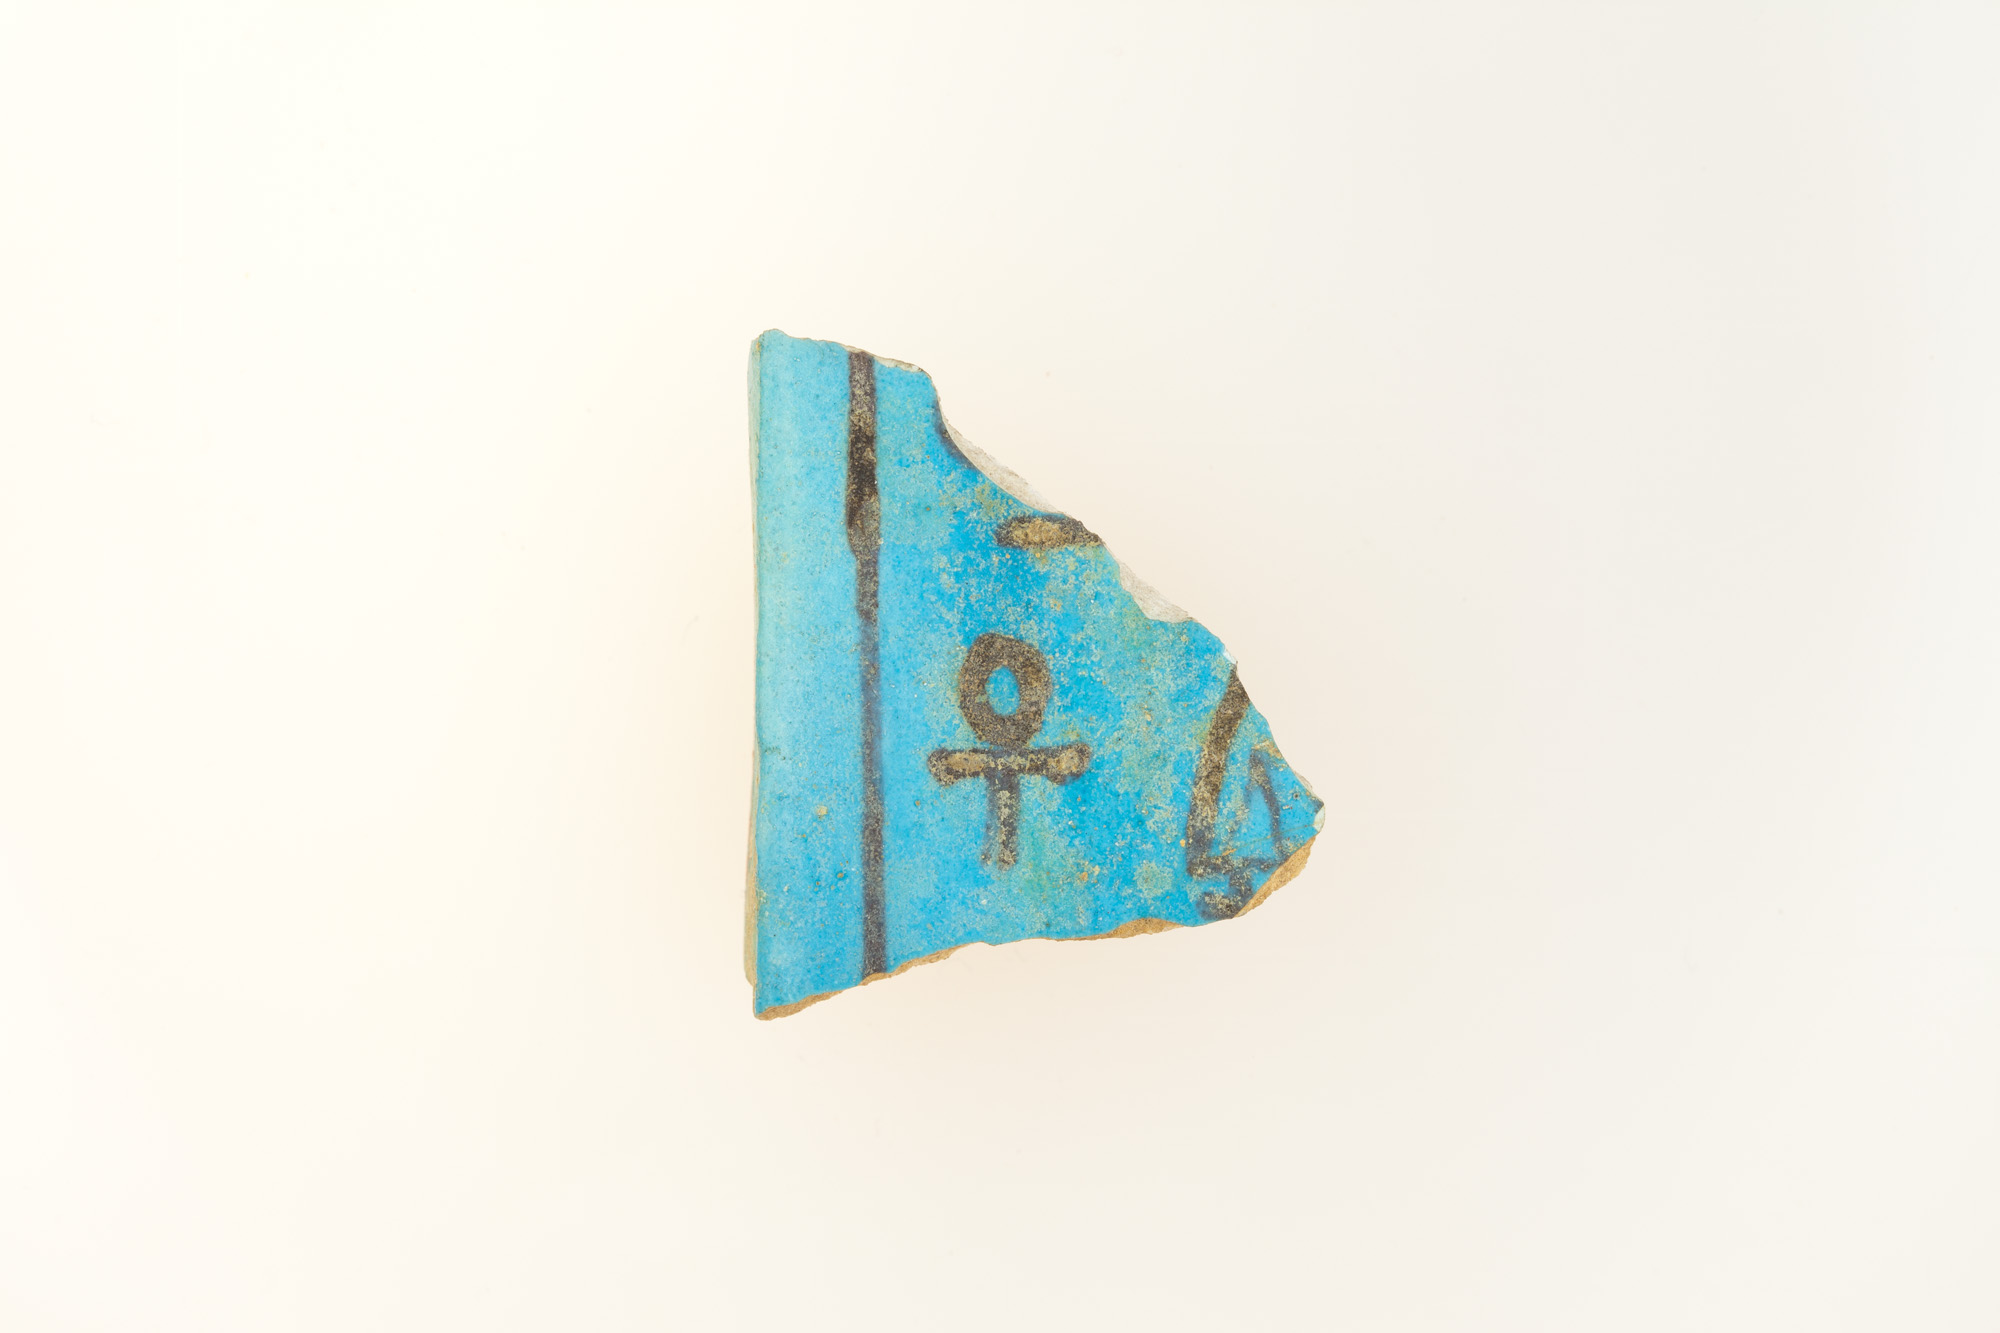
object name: menat fragment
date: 1479-1458 BCE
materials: faience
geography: egypt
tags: hathor